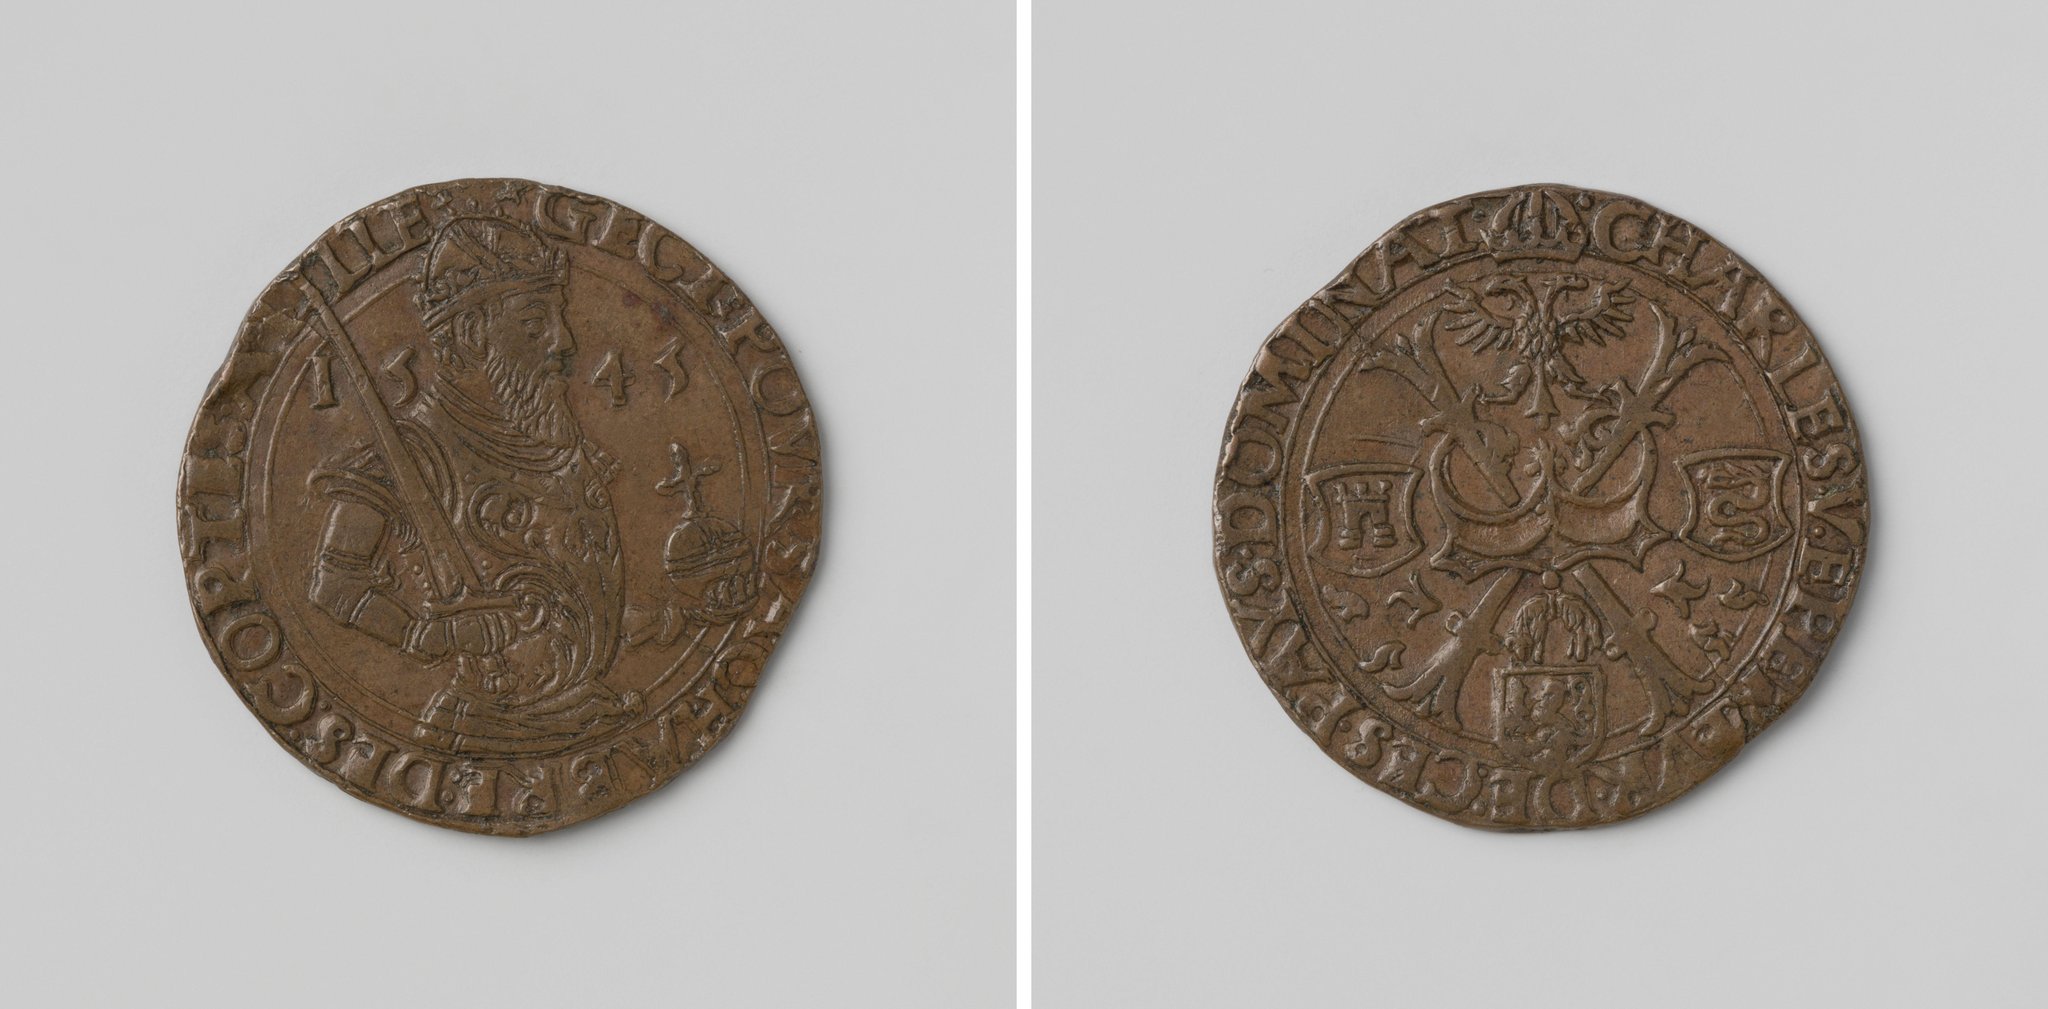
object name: jeton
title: Engels-Franse oorlog, penning van de rekenkamer van Vlaanderen te Rijssel, ter ere van Karel V, Duits keizer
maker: Anonymous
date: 1545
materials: copper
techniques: striking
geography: flanders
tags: ghent, charles v (holy roman emperor and king of spain), lille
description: Koperen penning. Voorzijde: portret van Karel V met kroon, rijksappel in linker- en zwaard in rechterhand tussen jaartal binnen omschrift. Keerzijde: vuurslag, waaraan orde van Gulden Vlies hangt, op Bourgondisch kruis onder tweekoppige adelaar, geflankeerd door en boven wapenschild binnen omschrift